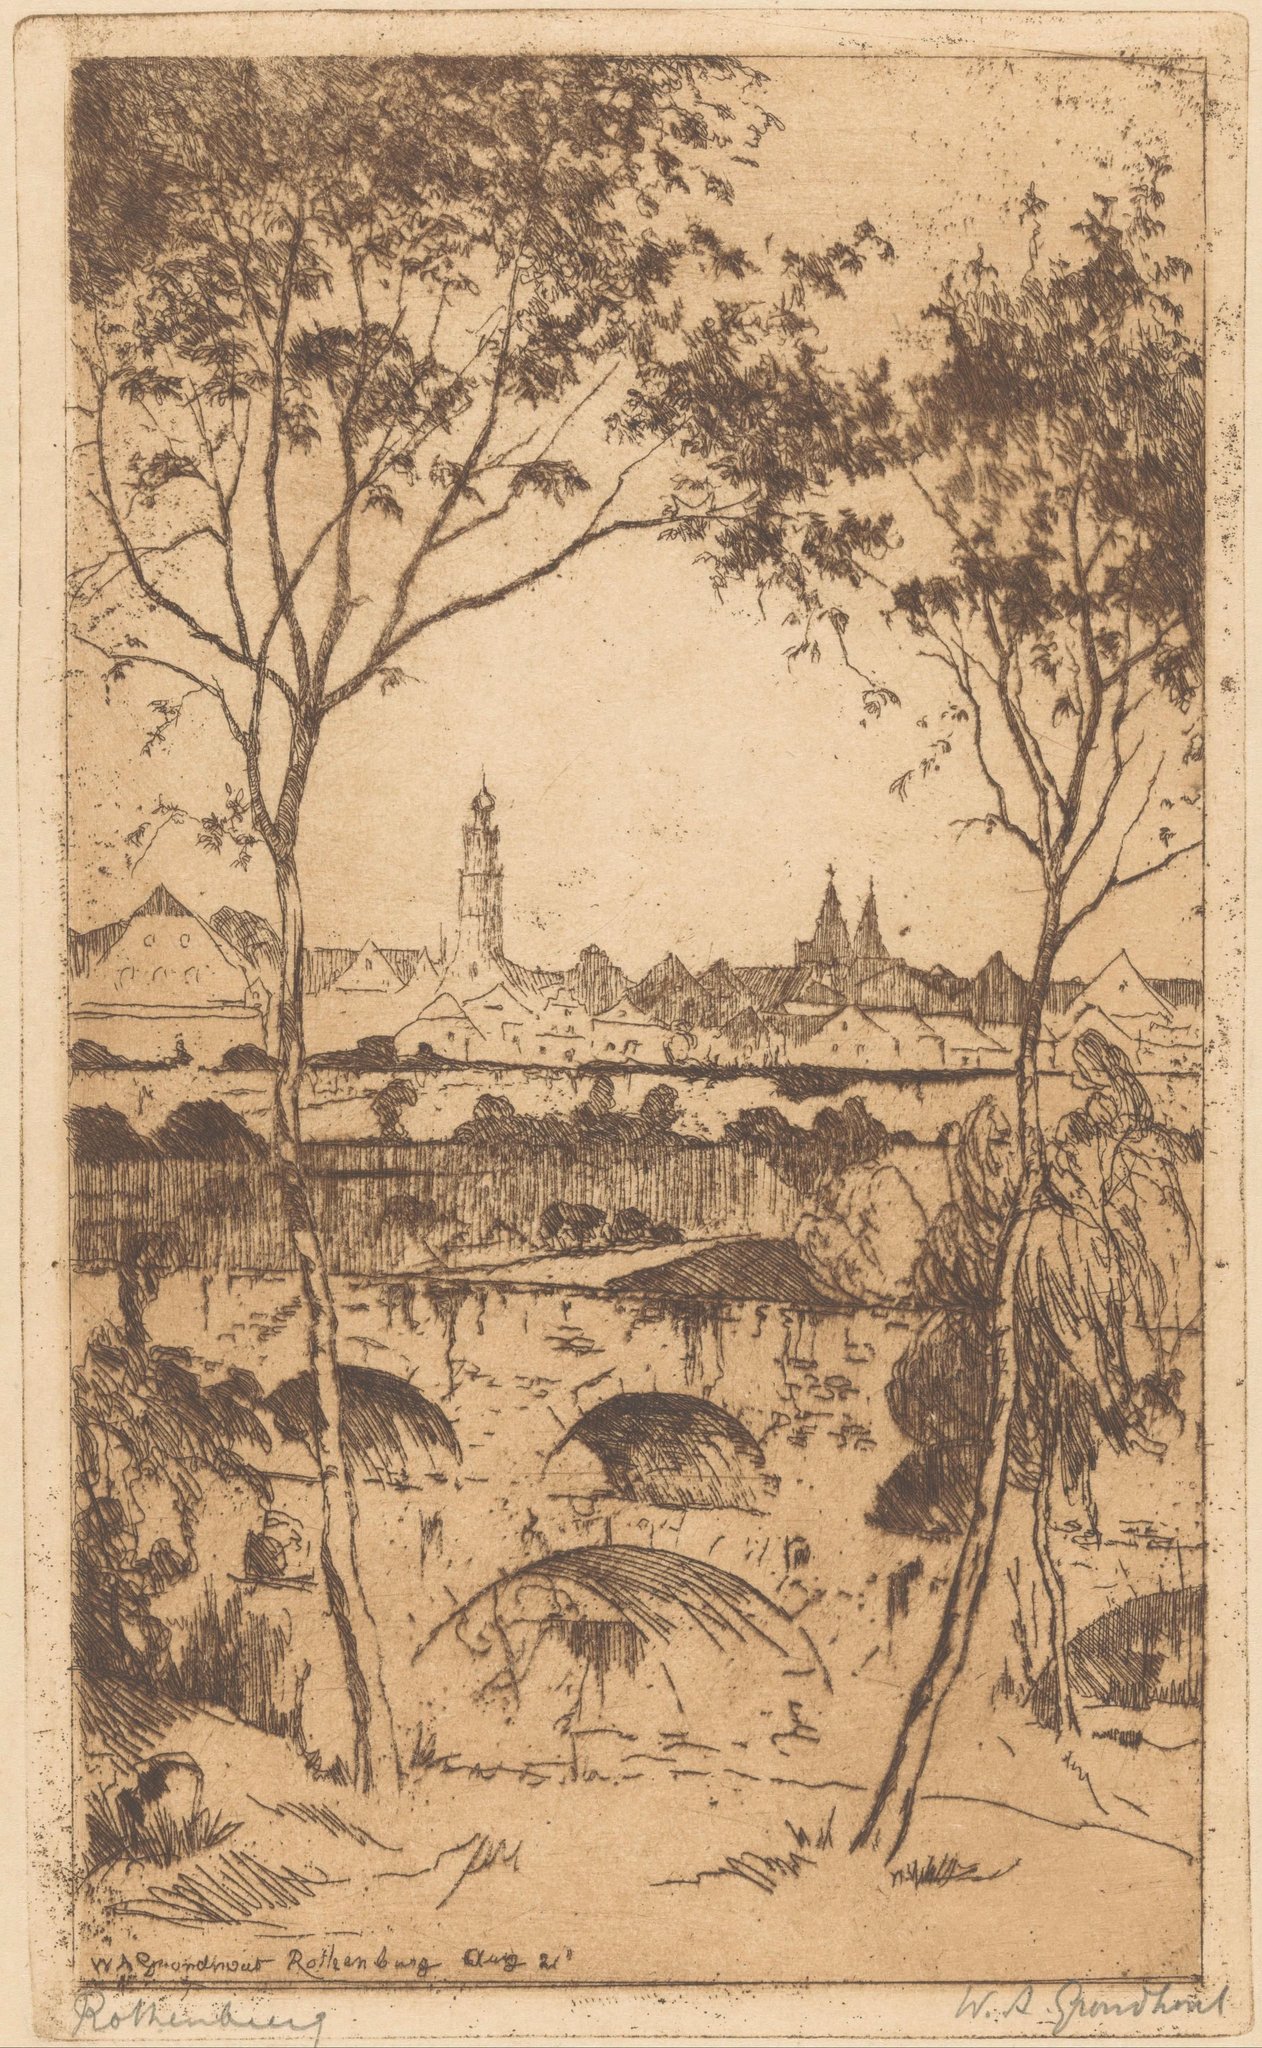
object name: print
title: Rothenburg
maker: willem adrianus grondhout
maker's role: draughtsman, painter, print maker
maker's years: 1878-1934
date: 1908-1921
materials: paper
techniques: etching, intaglio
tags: city-view, and landscape with man-made constructions, trees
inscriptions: collector's mark: Lugt 2228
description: Rothenburg ob der Tauber in Beieren. Op de voorgrond twee bomen. Links op de achtergrond de toren van het stadhuis.